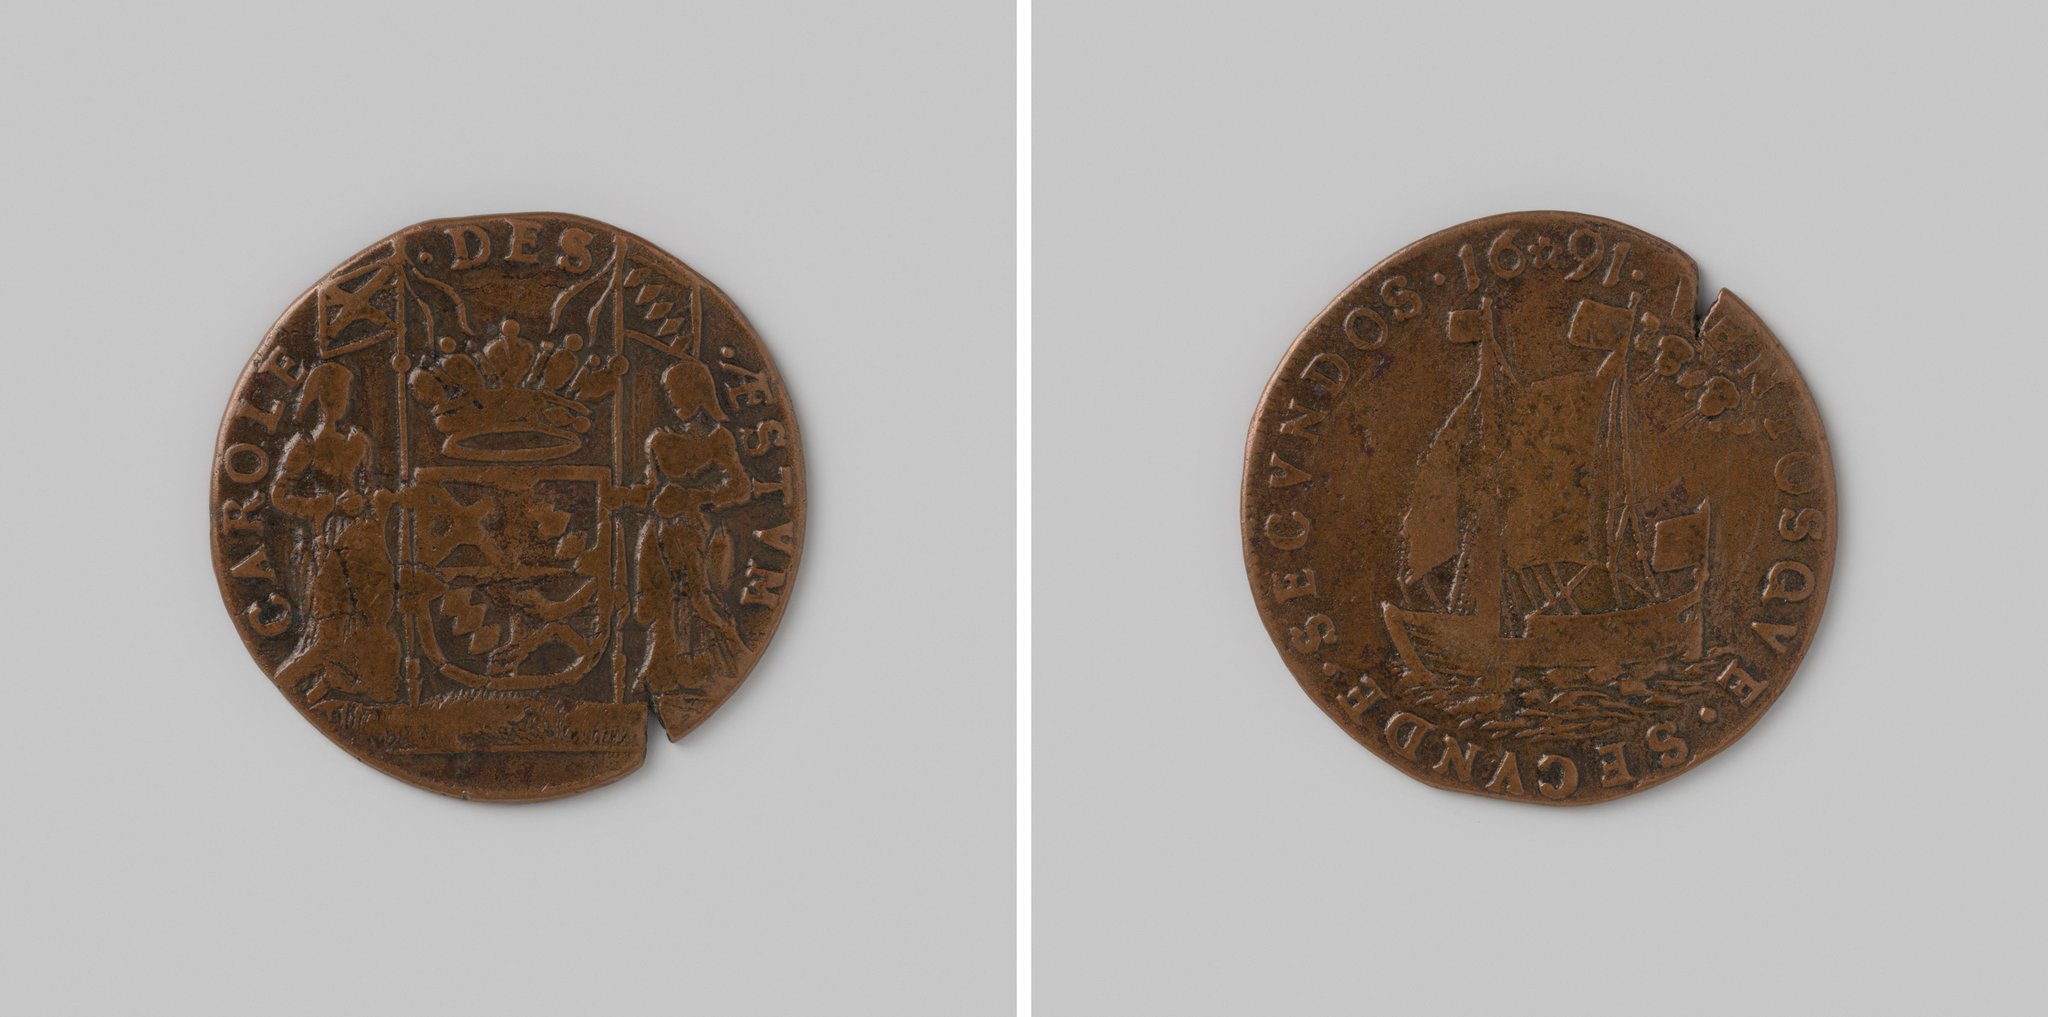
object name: jeton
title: Rekenpenning voor Willem van Hamme tresorier van Brusse 1691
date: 1691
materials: copper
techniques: striking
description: Koperen penning, op de voorzijde een gekroond wapenschild, met vrouwen met vaandels als dragers, met omschrift, op de keerzijde een zeilschip voor de wind, met omschrift.